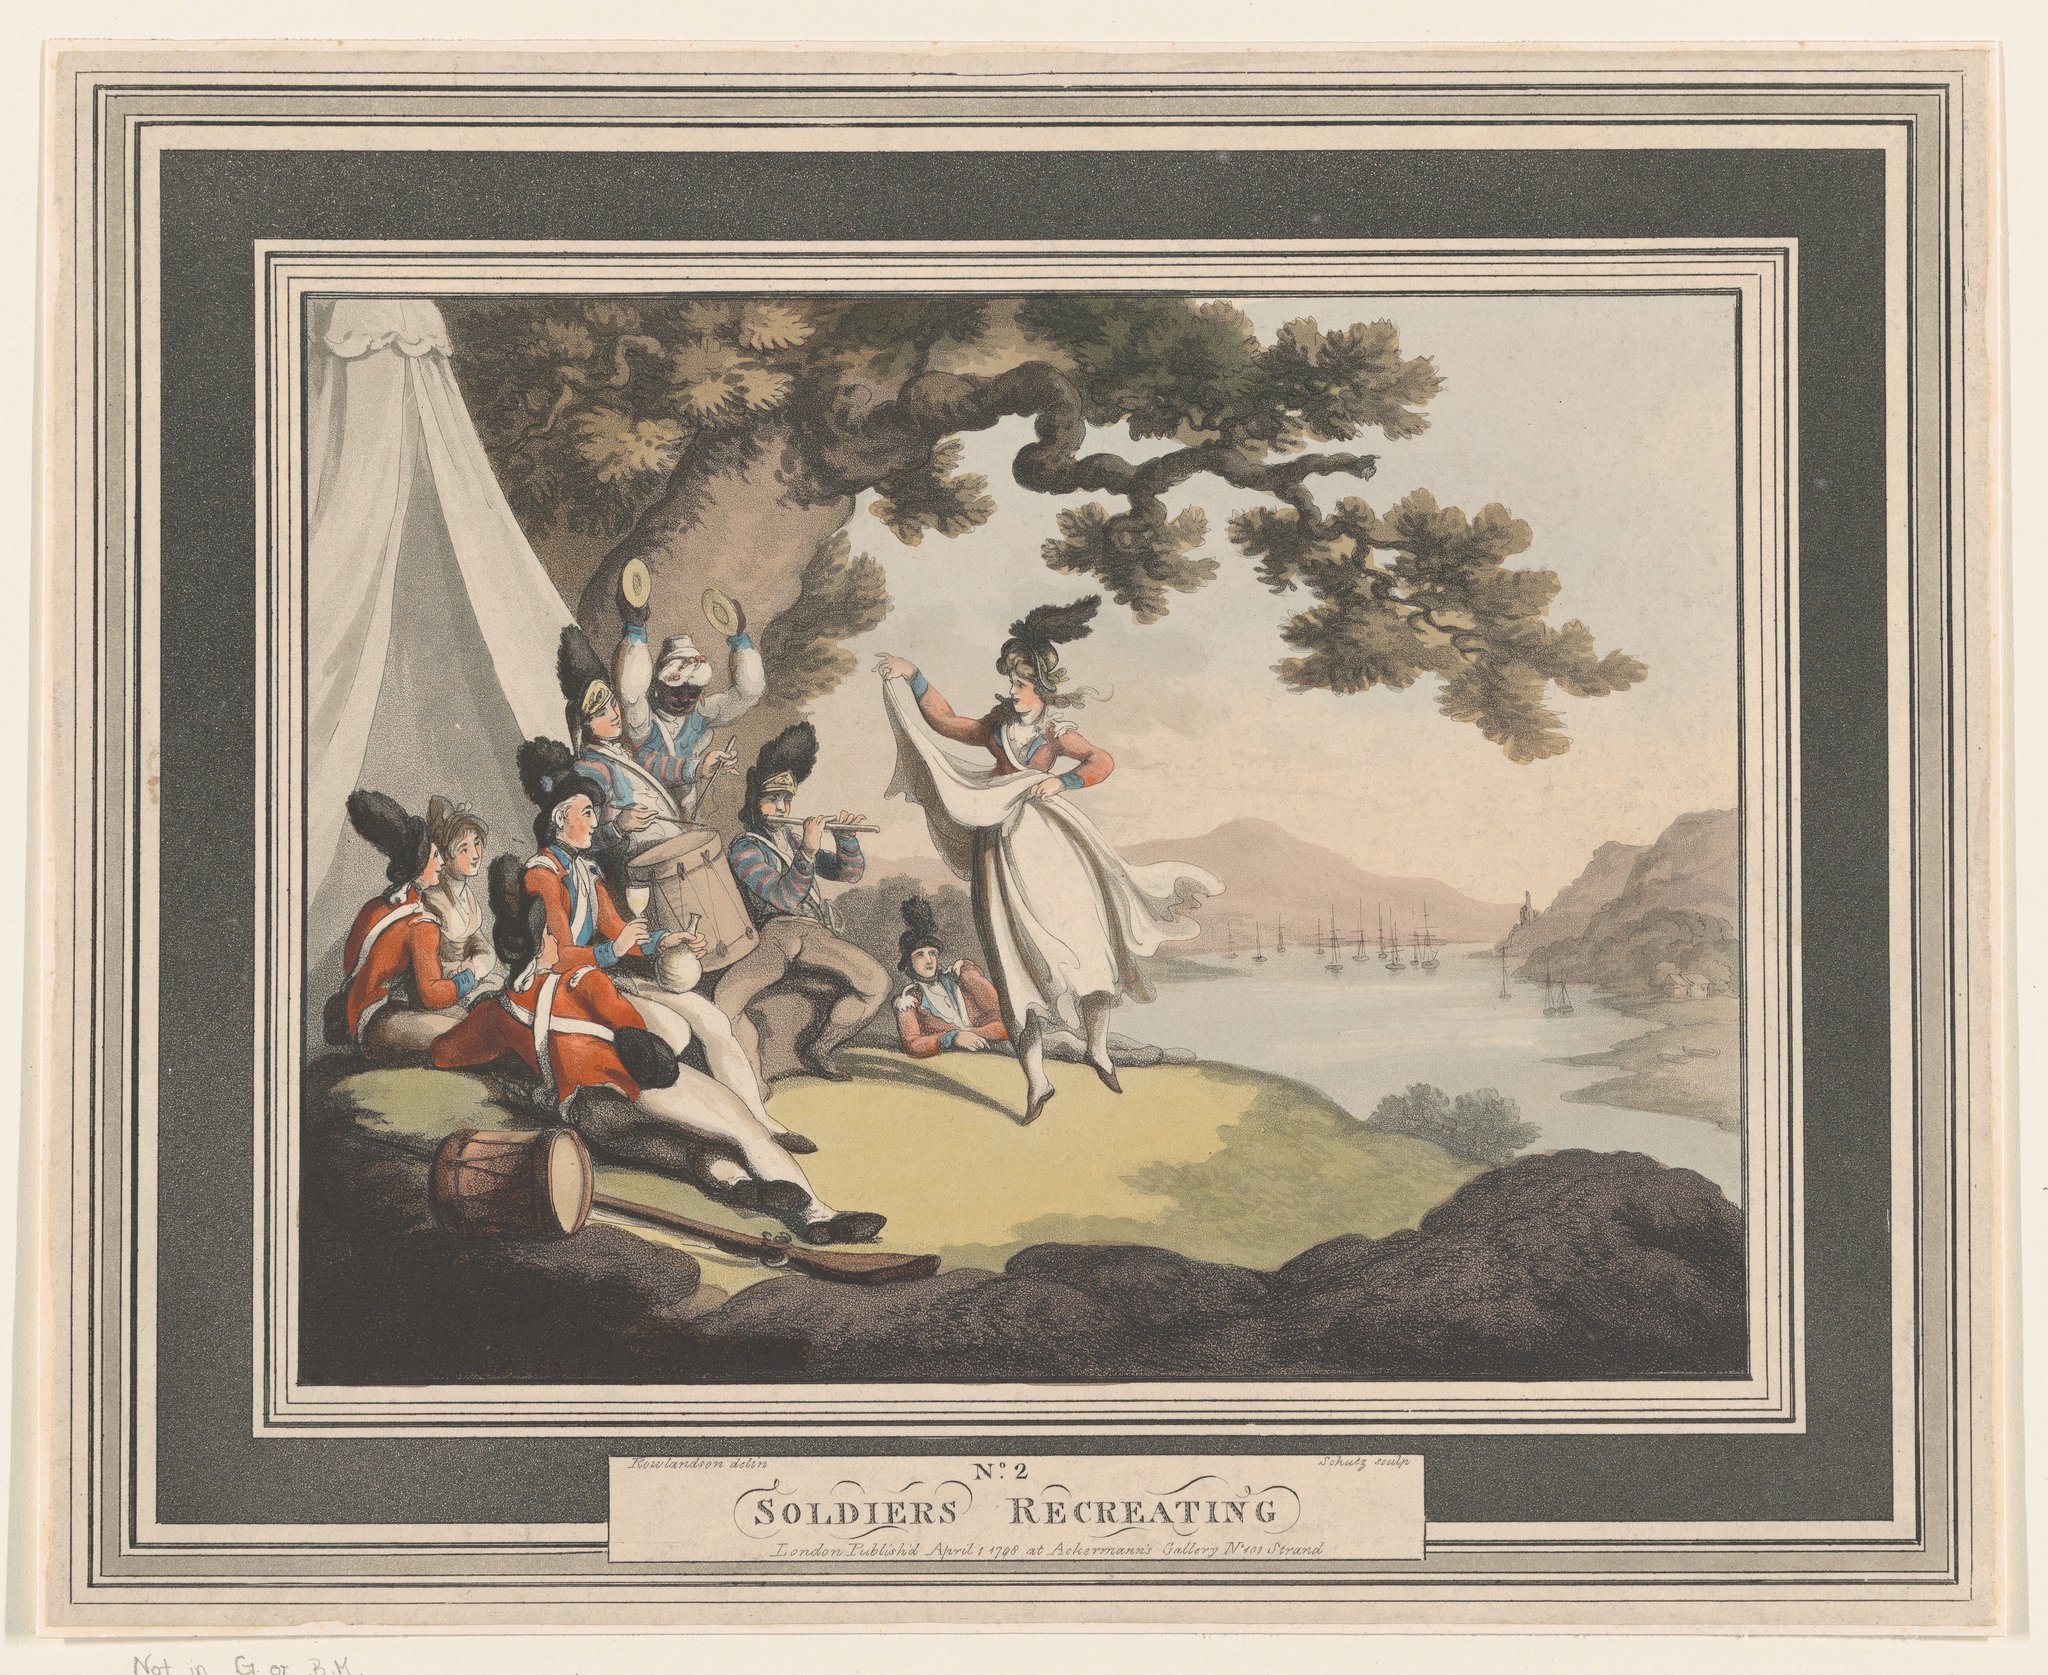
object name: print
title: Soldiers Recreating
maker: heinrich joseph schütz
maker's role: artist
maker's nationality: german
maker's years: 1800-1825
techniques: aquatint, etching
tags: soldiers,women,dancing,music